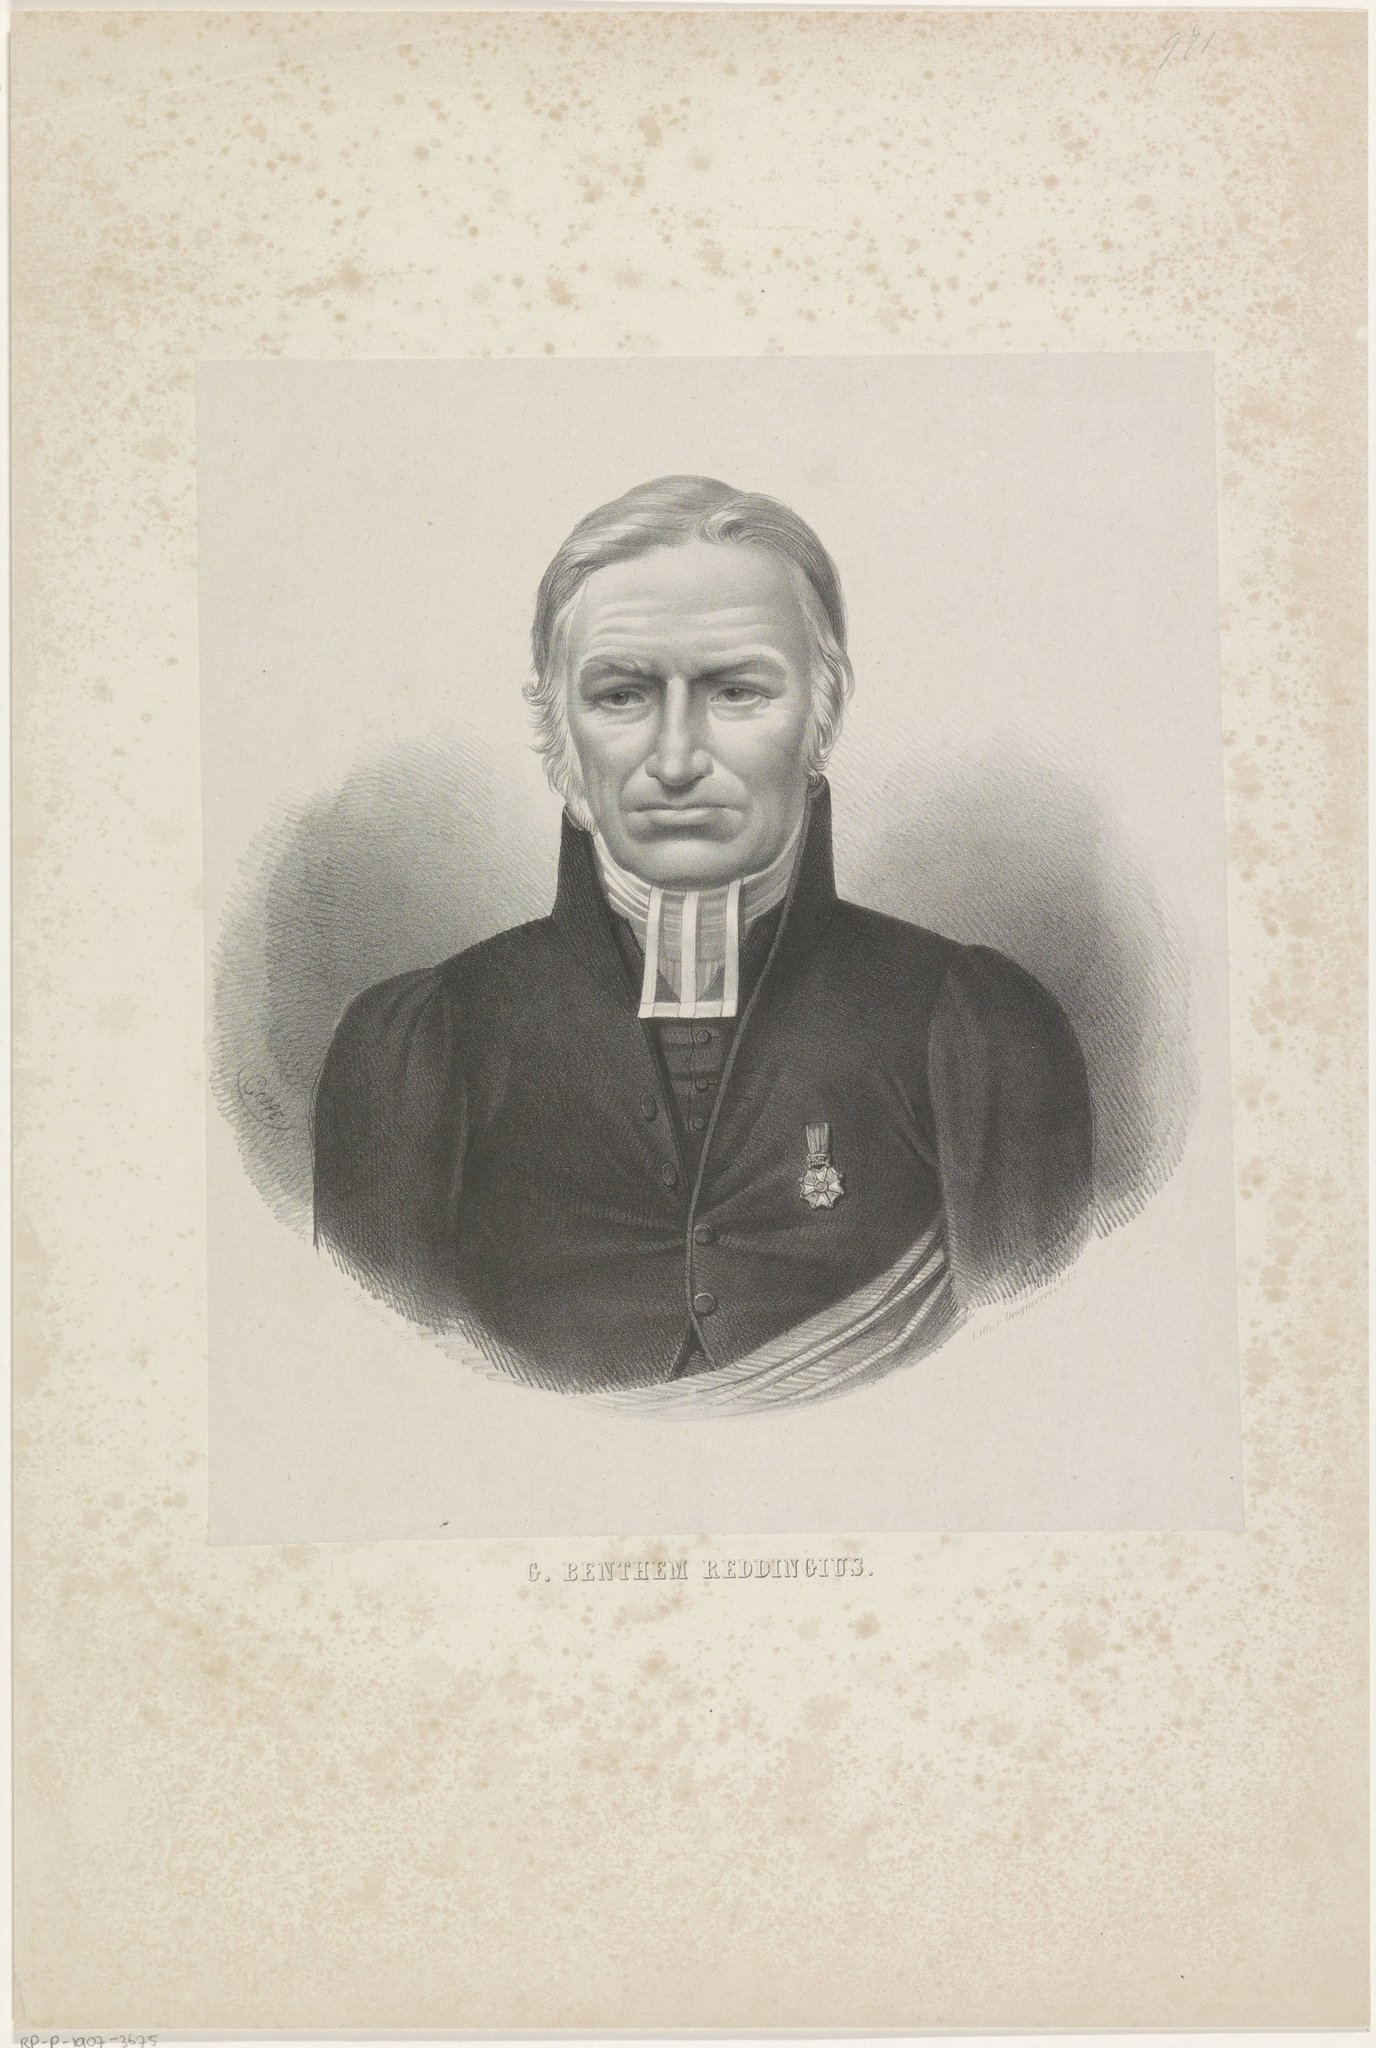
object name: print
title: Portret van Gerardus Benthem Reddingius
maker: wilhelmus cornelis chimaer van oudendorp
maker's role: print maker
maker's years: 1822-1873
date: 1832-1873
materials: paper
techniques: lithograph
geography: amsterdam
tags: historical persons (+ head (and shoulders) (portrait)), knighthood order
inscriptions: collector's mark: Lugt 2228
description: De geportretteerde is frontaal afgebeeld en draagt een bef en een ridderorde op de borst. Onder het portret zijn naam.